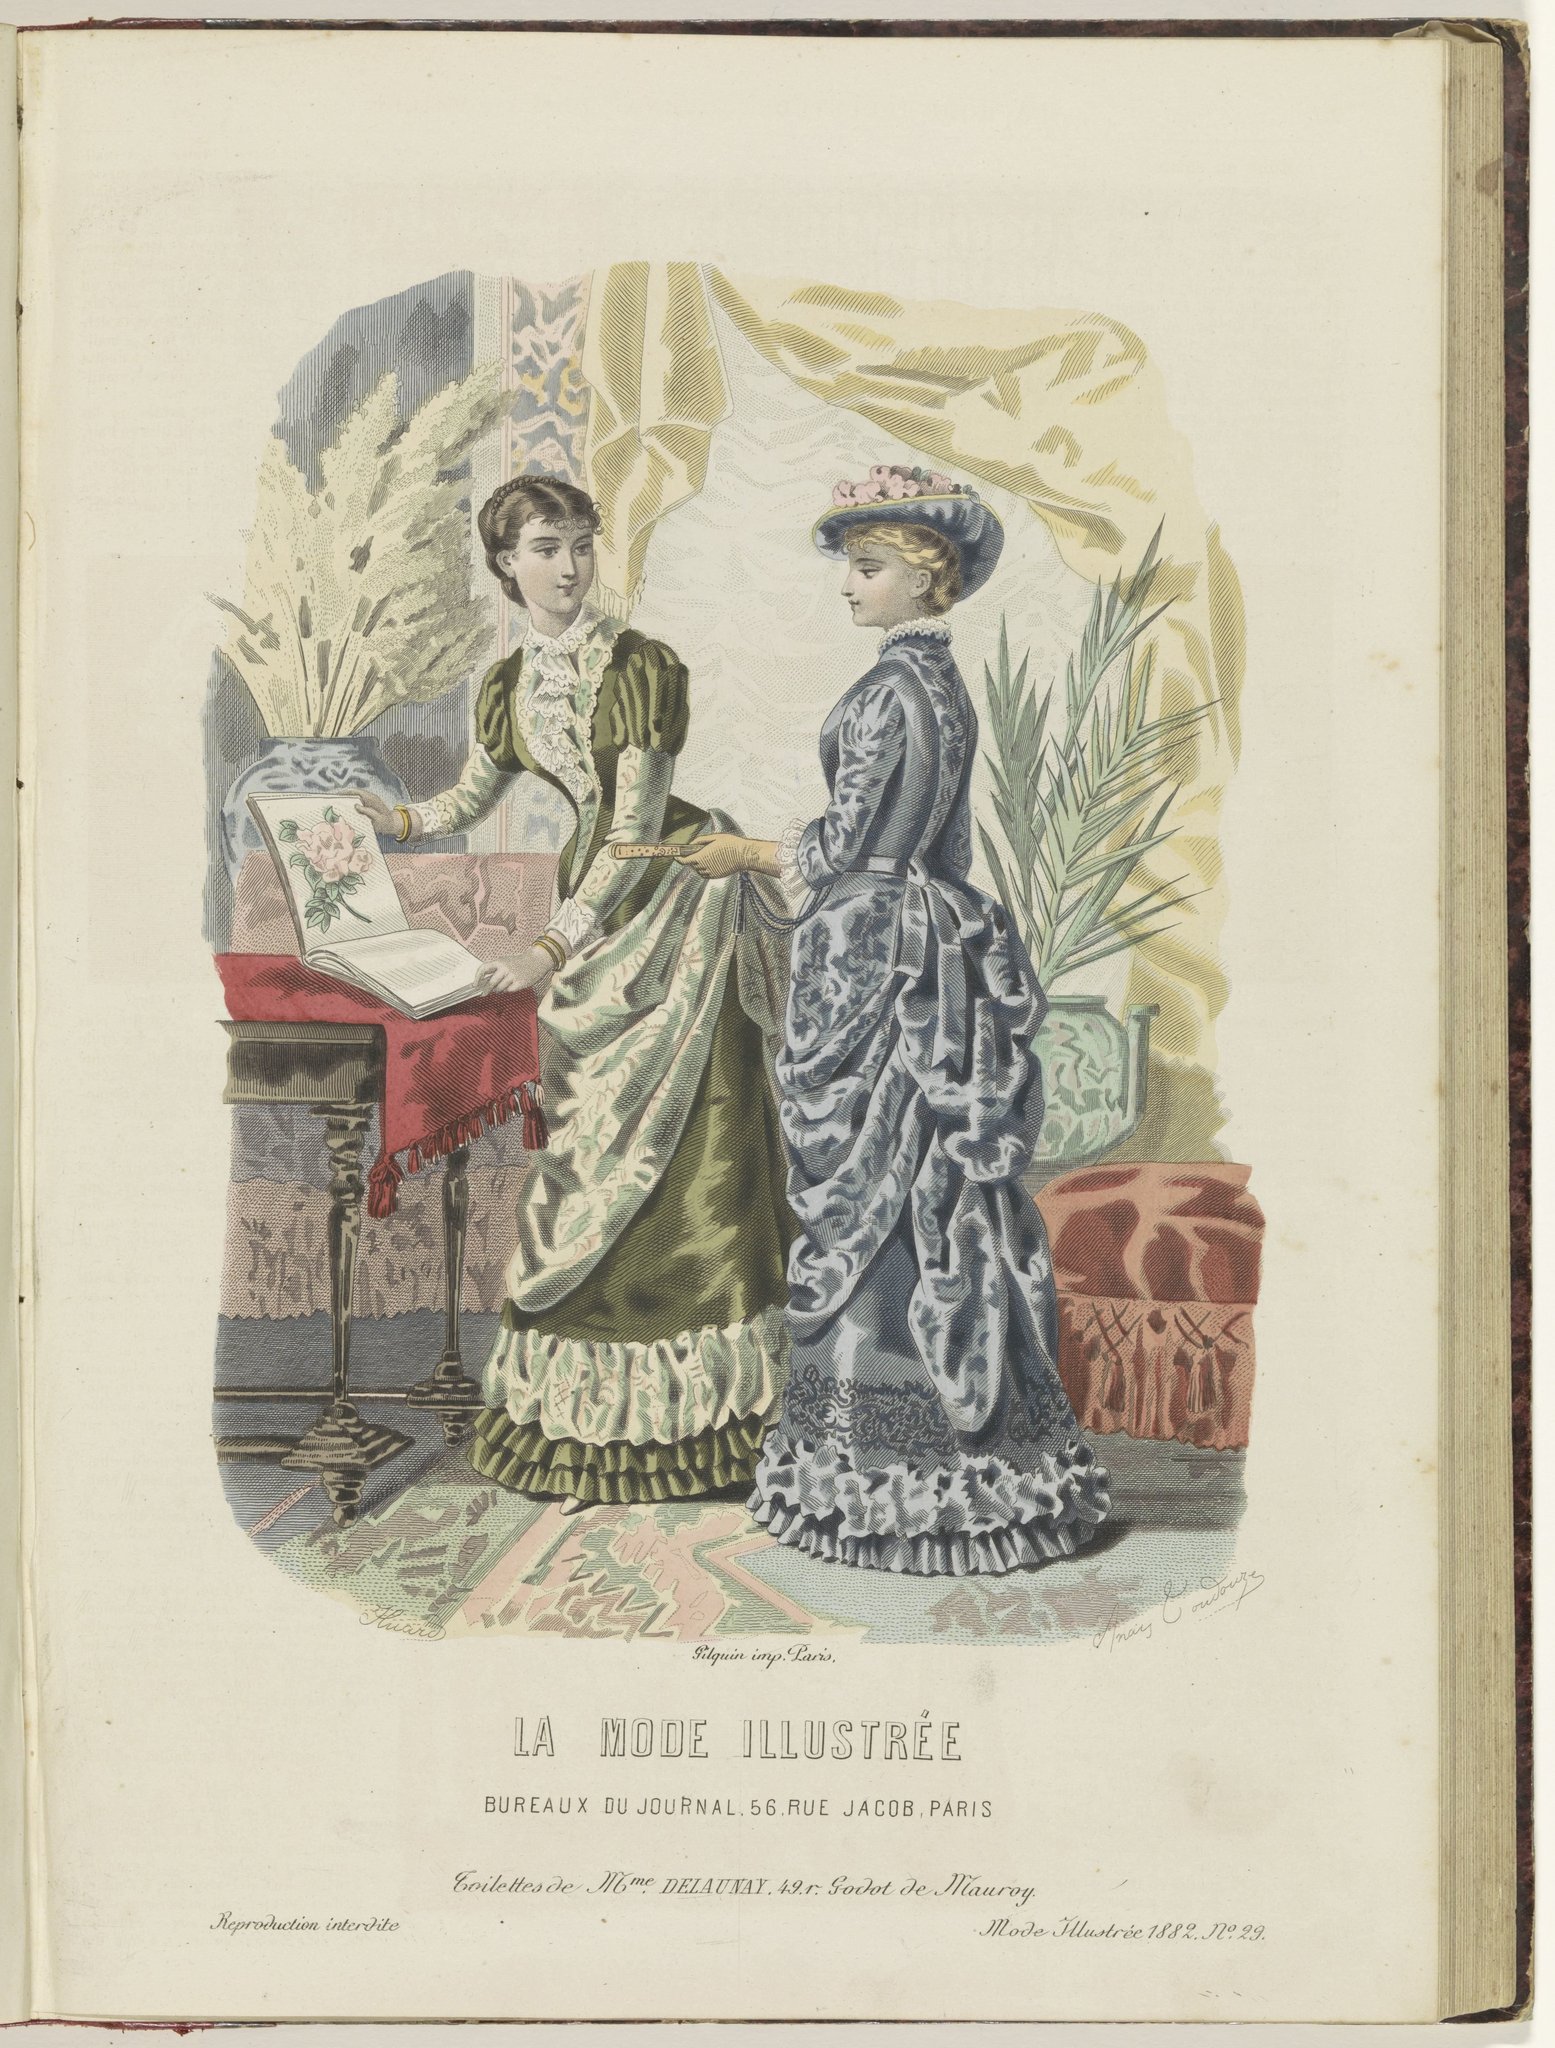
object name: magazine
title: La Mode Illustrée, Journal de la Famille, 1882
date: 1882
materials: paper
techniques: engraving, hand coloring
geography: paris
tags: fashion plates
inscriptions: date